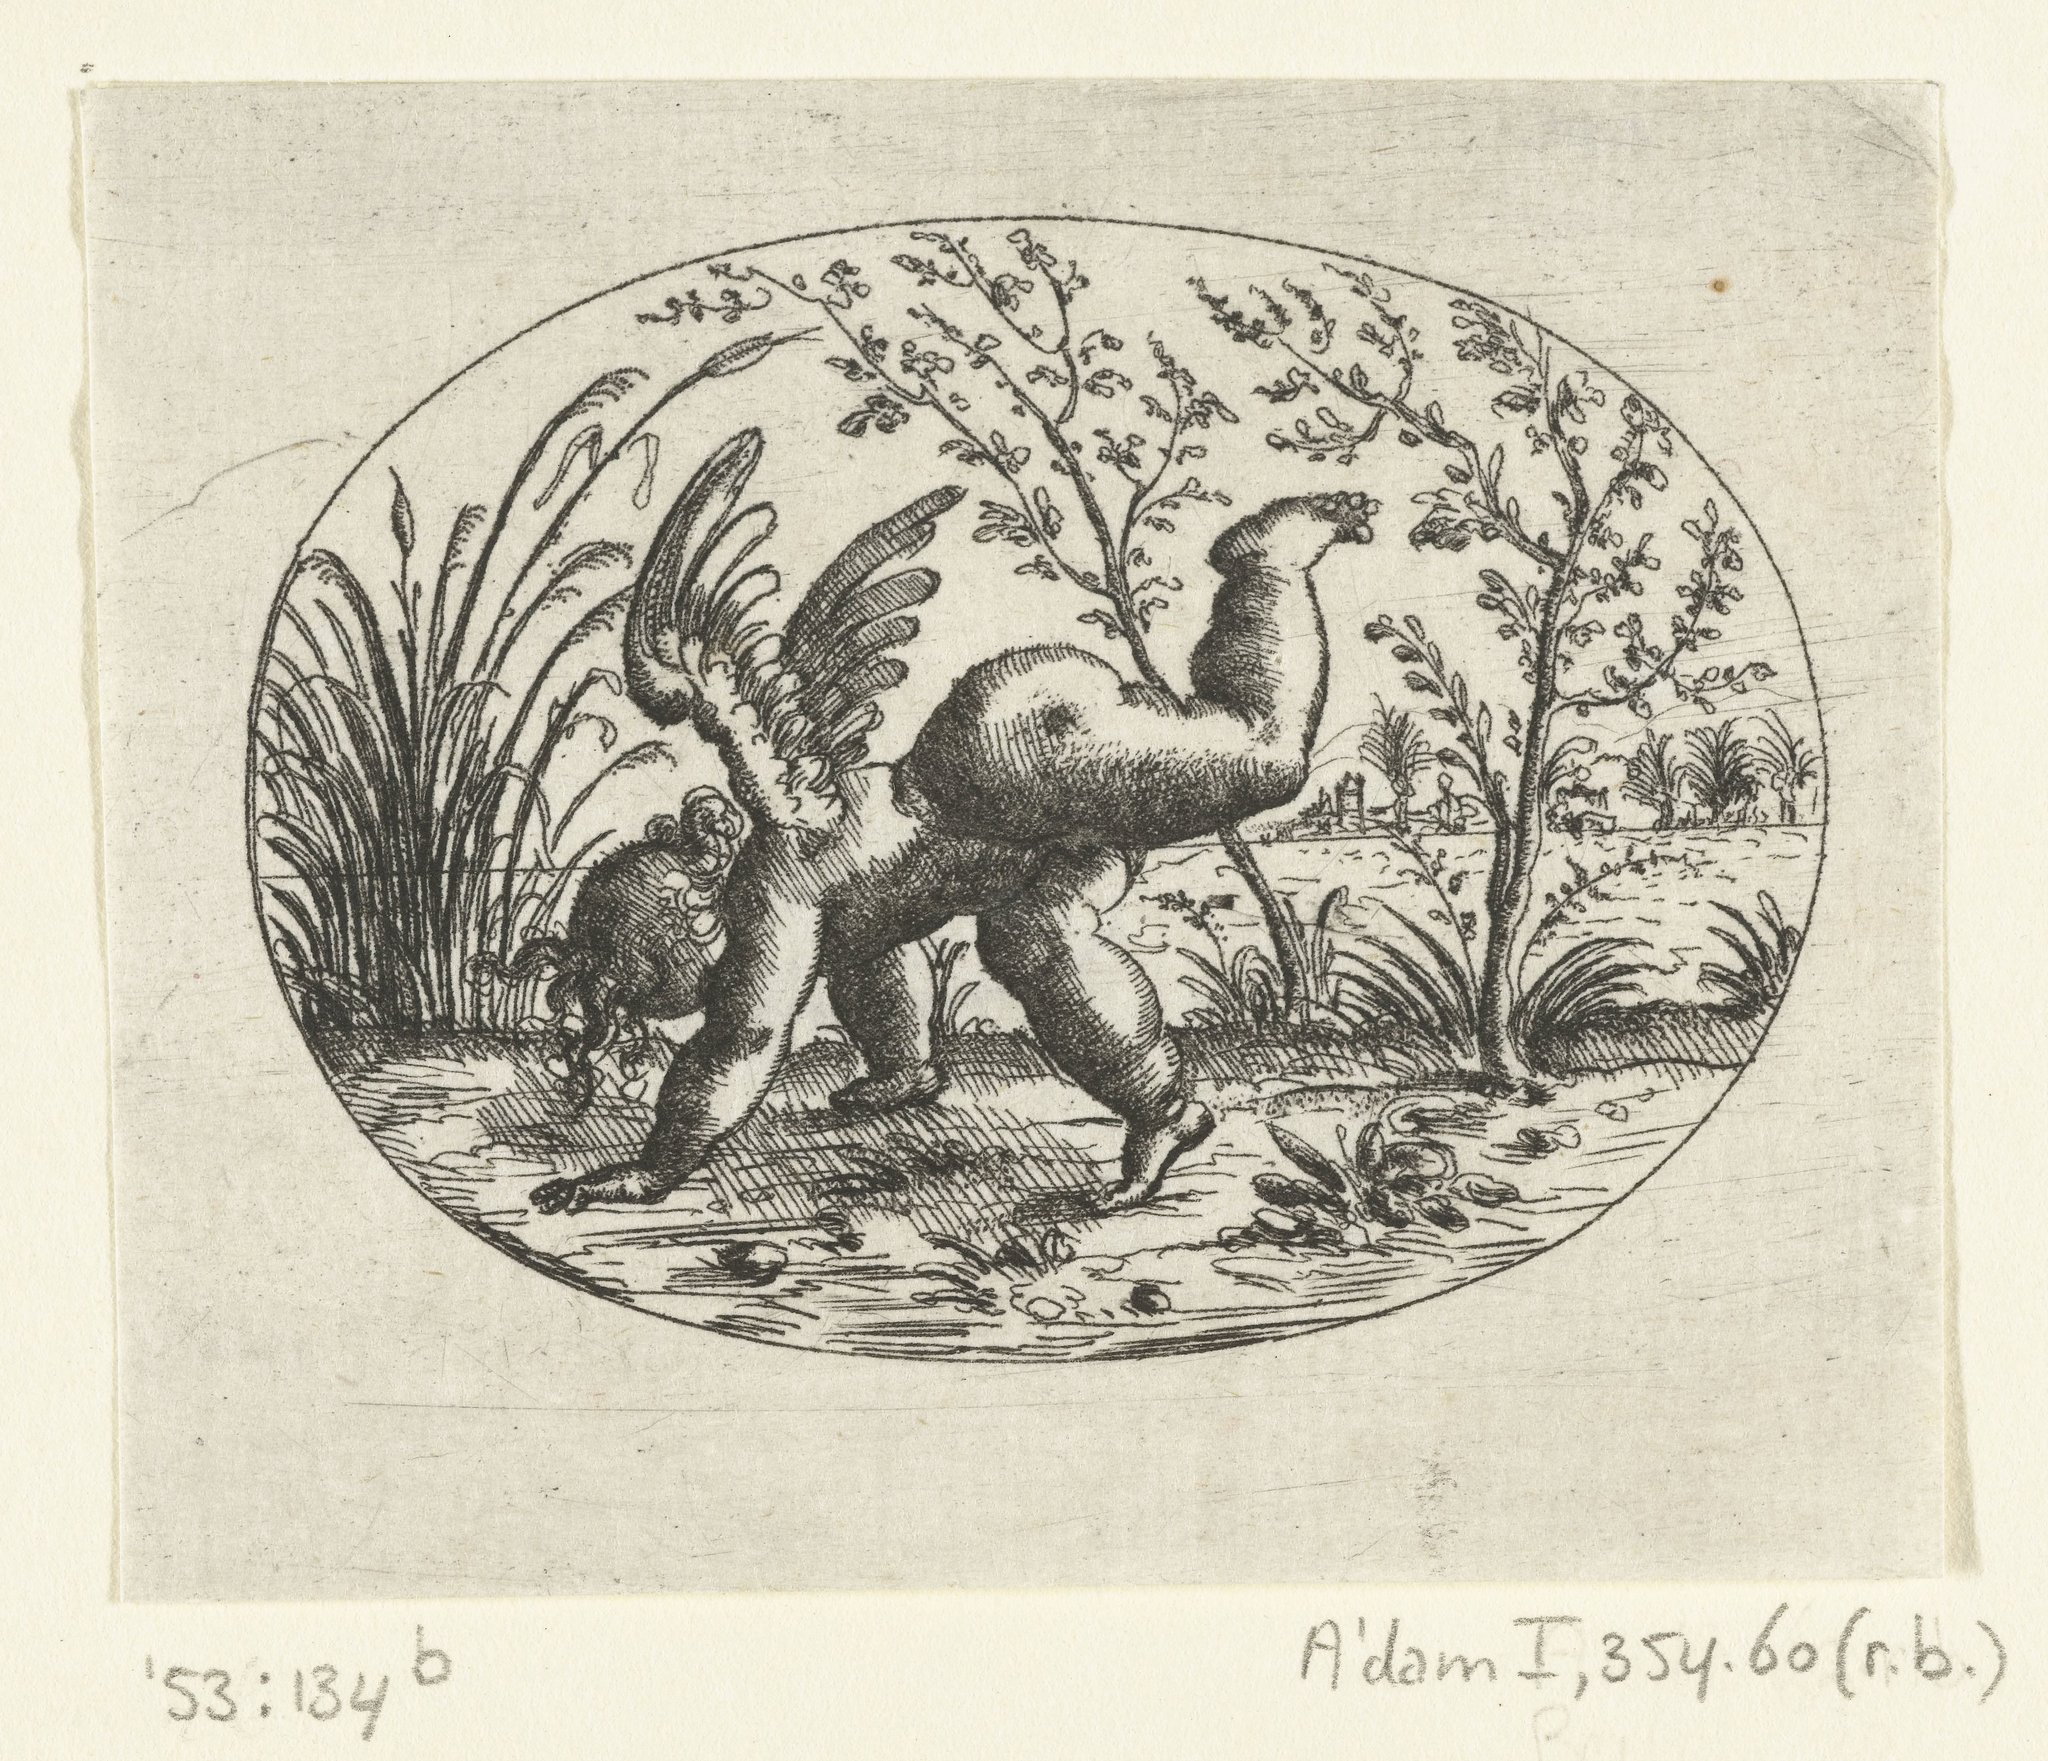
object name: ornament print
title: Liggend ovaal met putto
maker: christoph jamnitzer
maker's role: draughtsman, goldsmith, print maker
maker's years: 1563-1618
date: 1573-1610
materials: paper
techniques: etching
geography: germany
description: Een putto die bezig is op zijn handen te gaan staan. Blad uit een serie vlakdecoraties met grotesken, cartouches, ovalen, mascarons, putti en fantastische wezens. De serie bestaat uit drie titelbladen, twee tekstbladen met de opdracht en het voorwoord en 60 bladen, verdeeld over drie boeken.